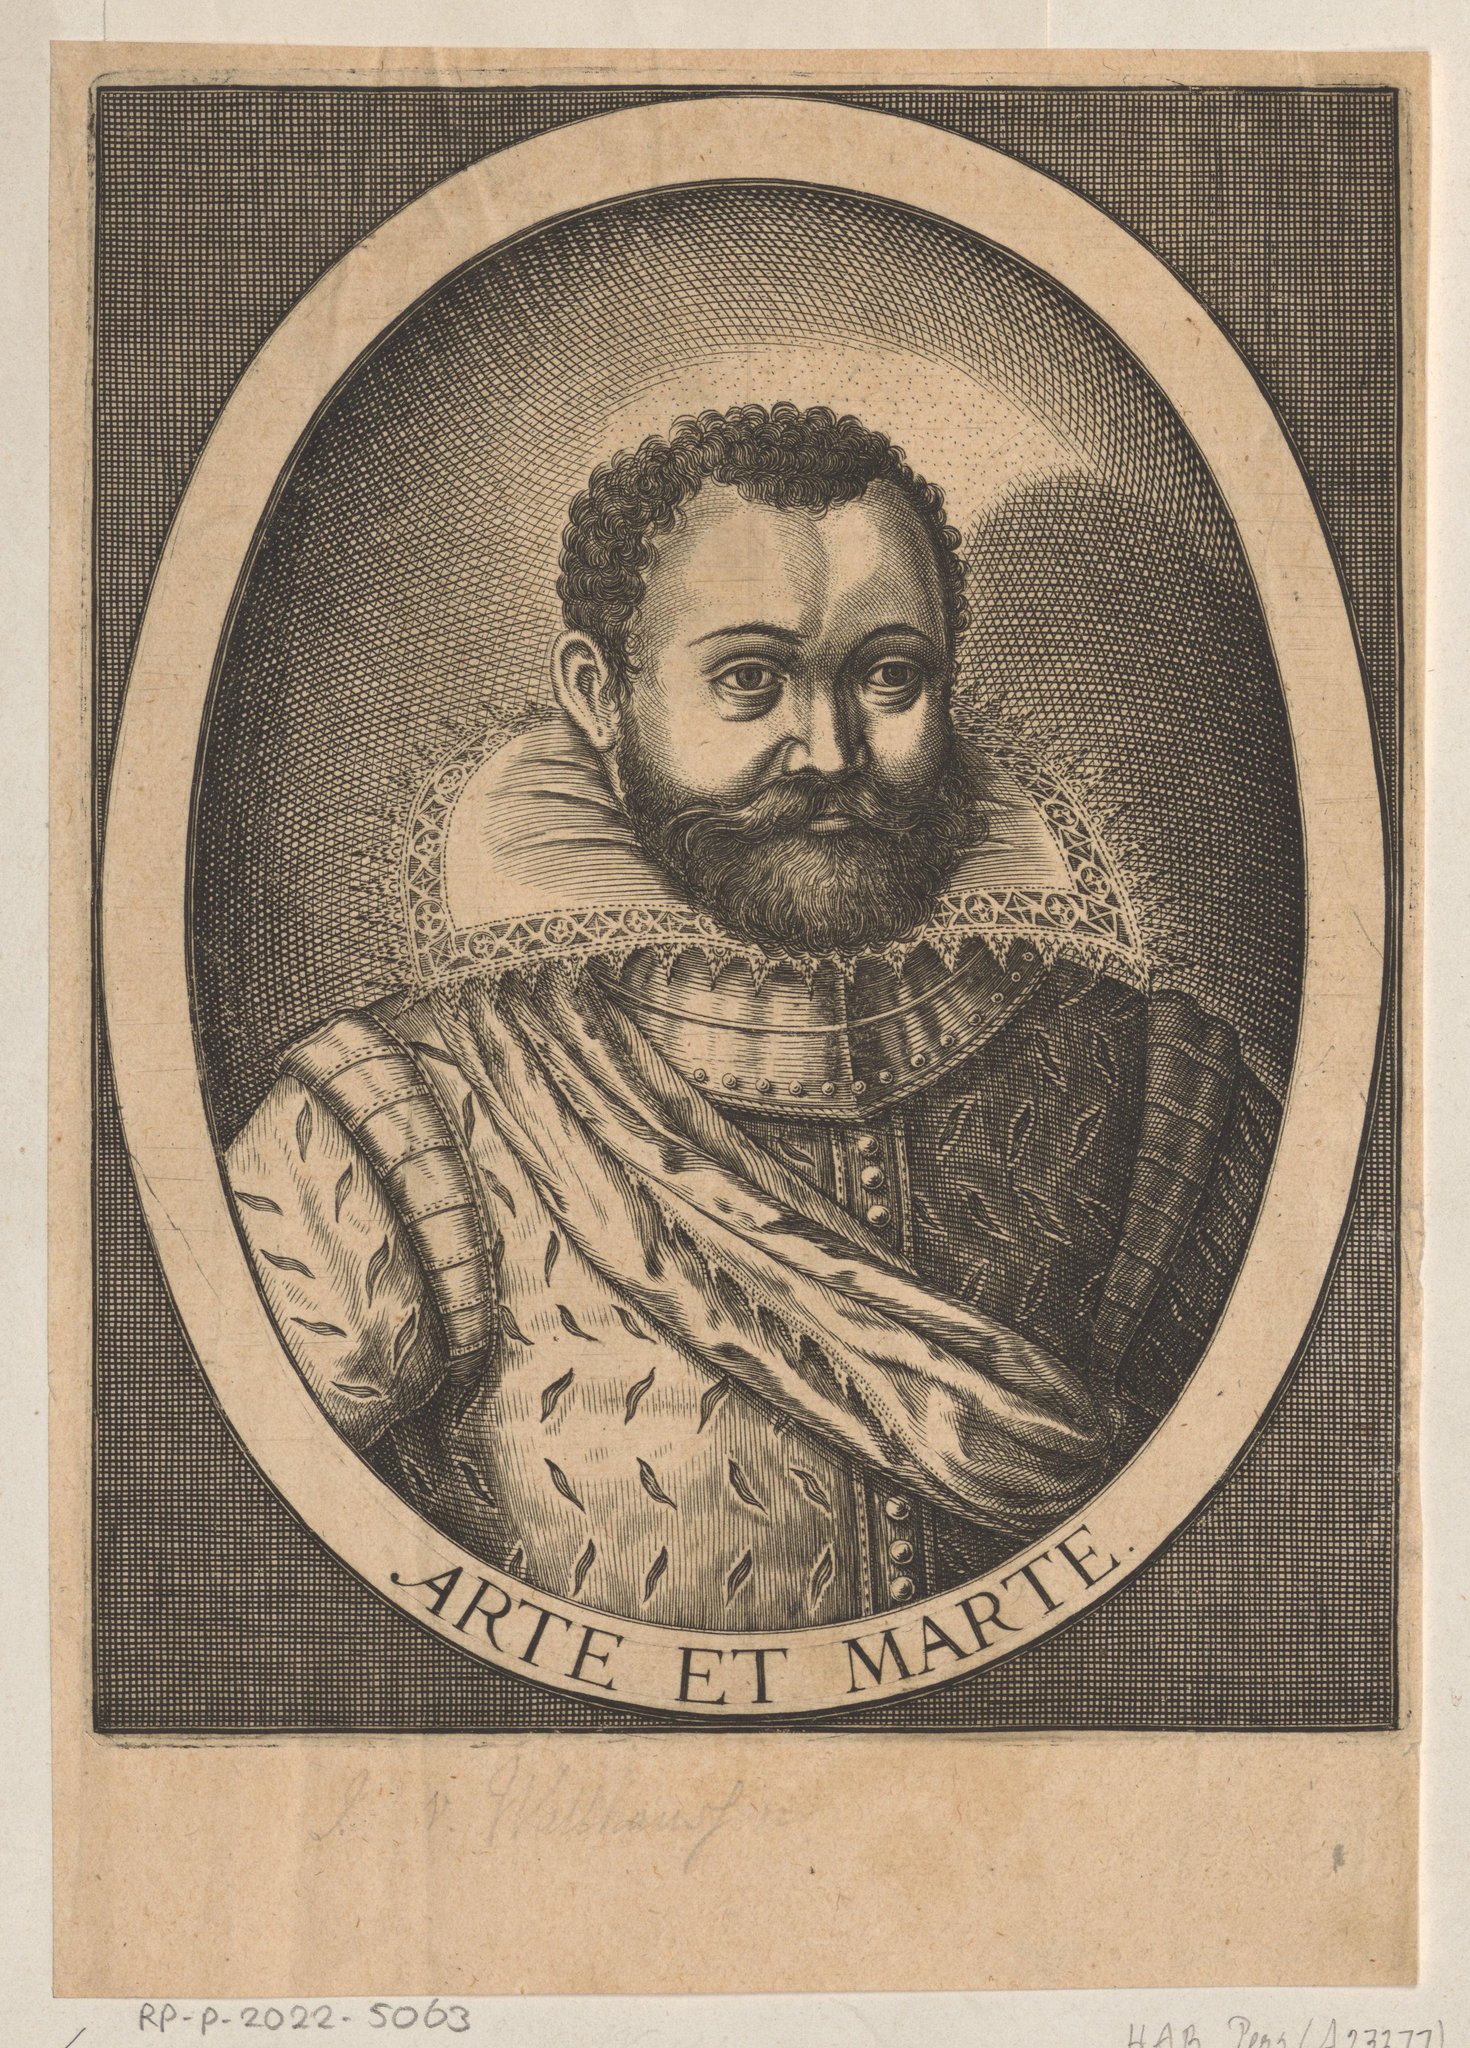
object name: print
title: Portret van Johann Jacob von Wallhausen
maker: Anonymous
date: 1617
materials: paper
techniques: engraving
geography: germany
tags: johann jacob von wallhausen, historical persons, portrait of a writer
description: Prent waarschijnlijk uit: Wallhausen, Johann Jacob von. Corpus militare, darinnen das heutige Kriegswesen in einer perfecten und absoluten idea begriffen und vorgestelt wirdt (...). Hanau: Johann Jacob von Wallhausen, 1617.